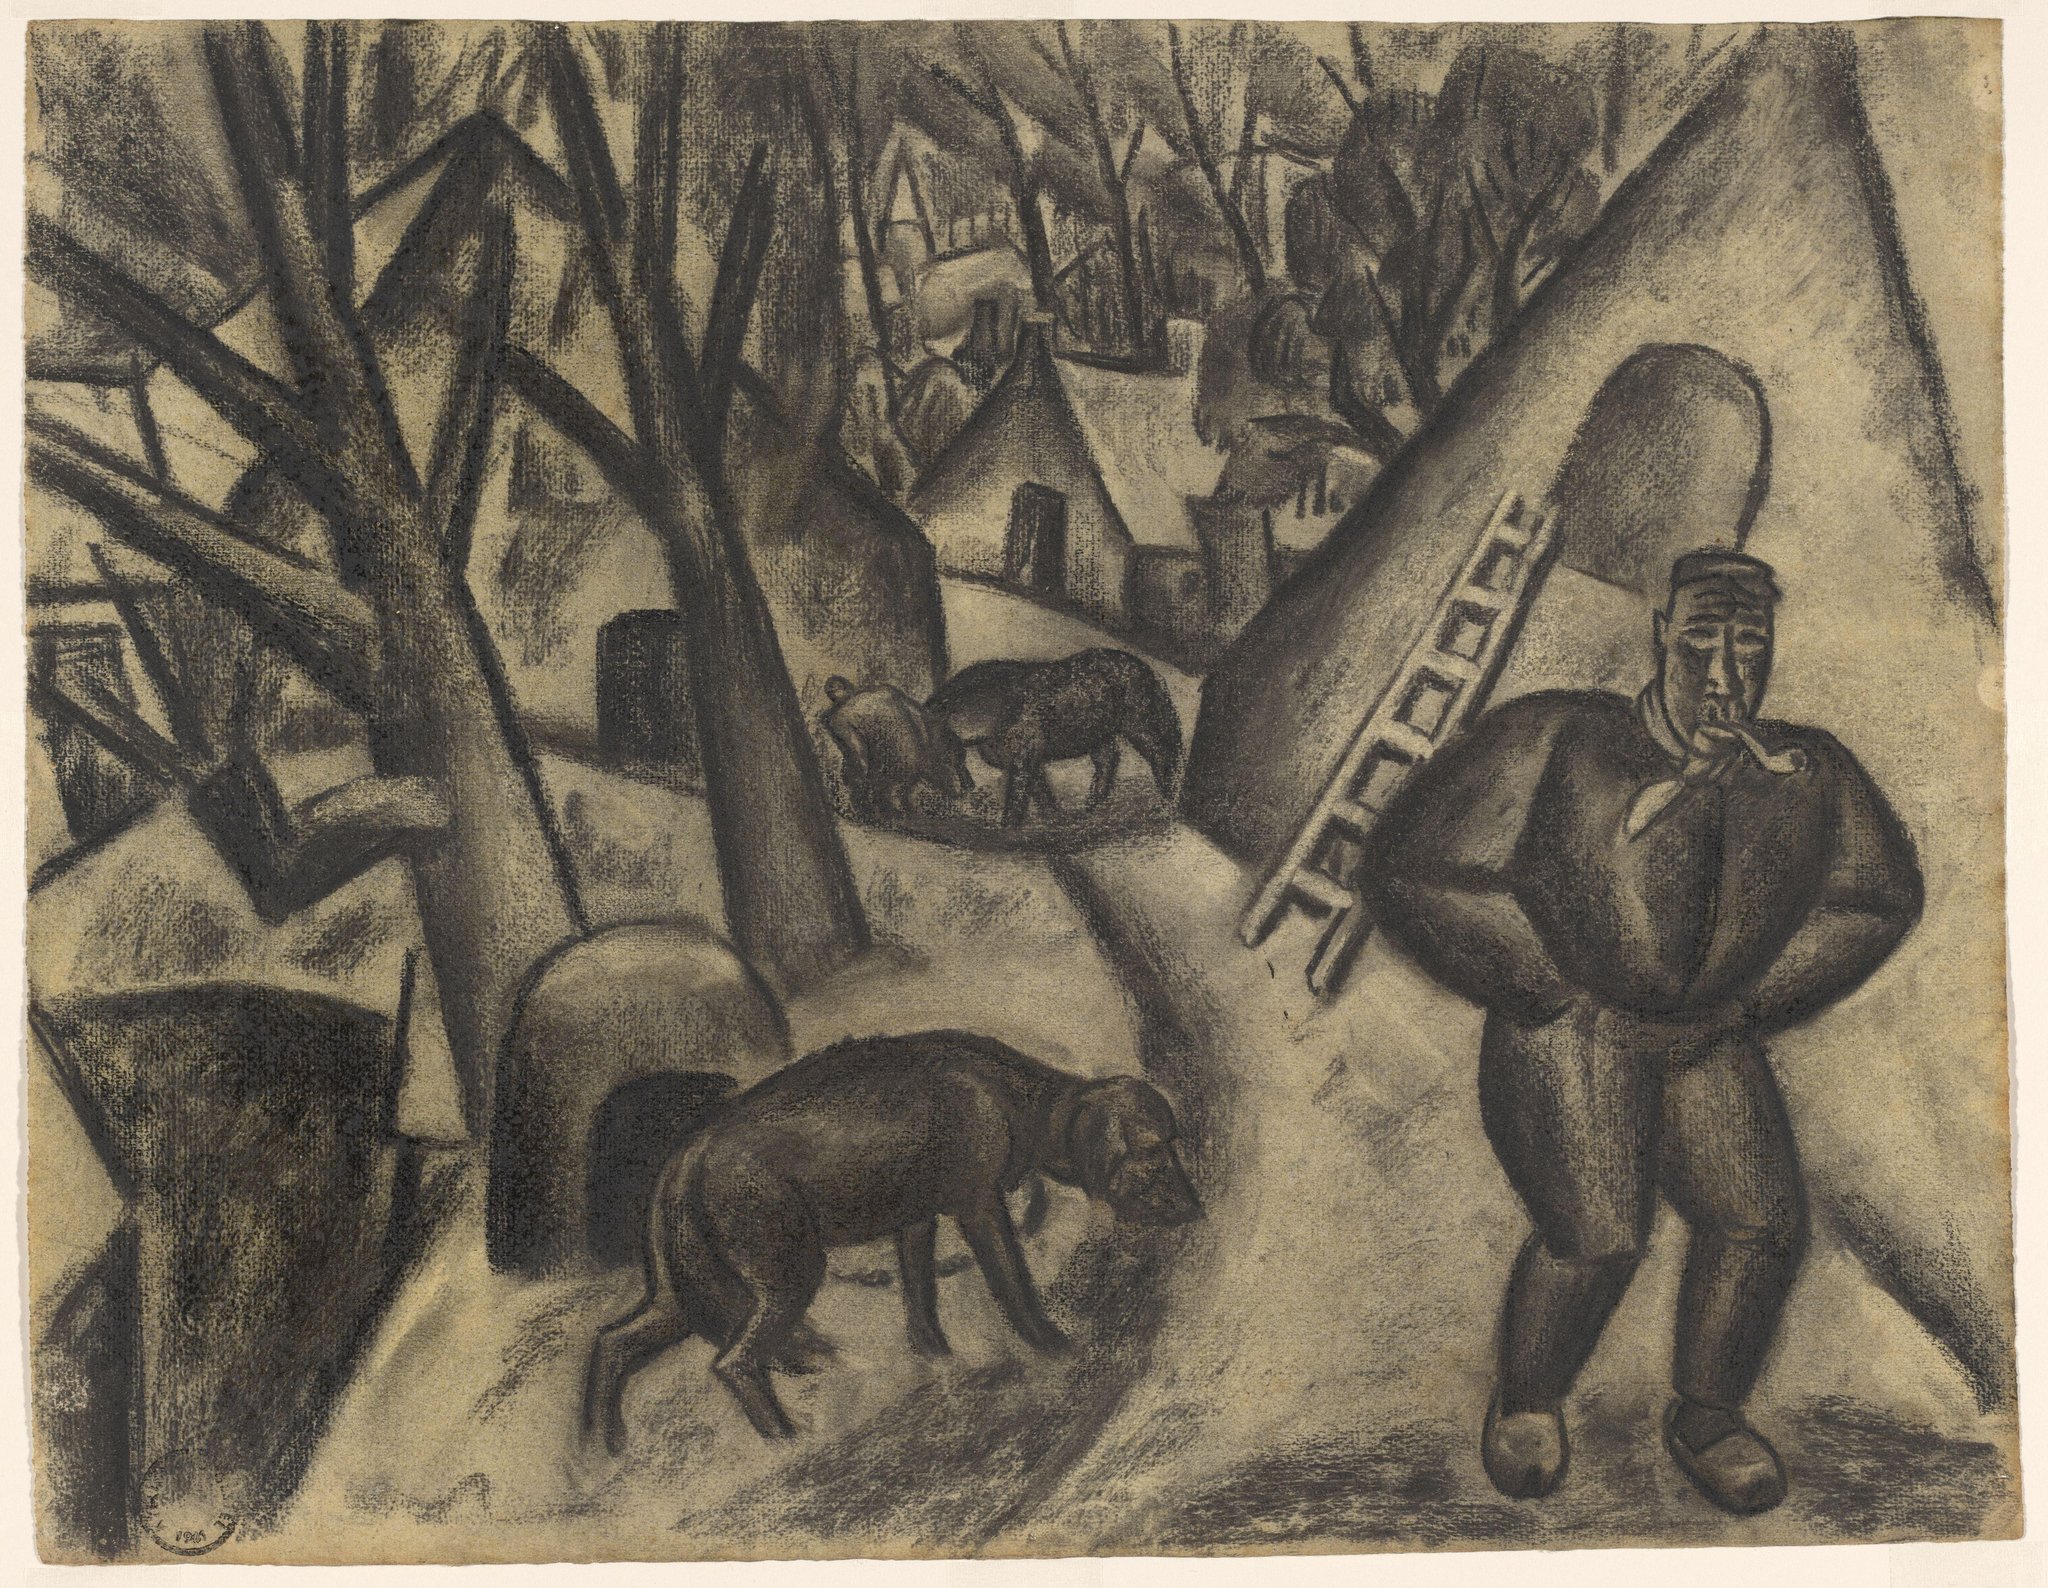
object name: drawing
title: Boer met hond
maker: leo gestel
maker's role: draughtsman, print maker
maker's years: 1881-1941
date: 1927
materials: chalk, charcoal, paper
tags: farmers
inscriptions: workshop stamp: ‘ATELIER LEO GESTEL 1941’, workshop stamp: ‘ATELIER LEO GESTEL 1941’, inscription: ‘VLAANDEREN portret 1926/27’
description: De huidige titel is door het Rijksmuseum overgenomen van het Instituut Collectie Nederland.